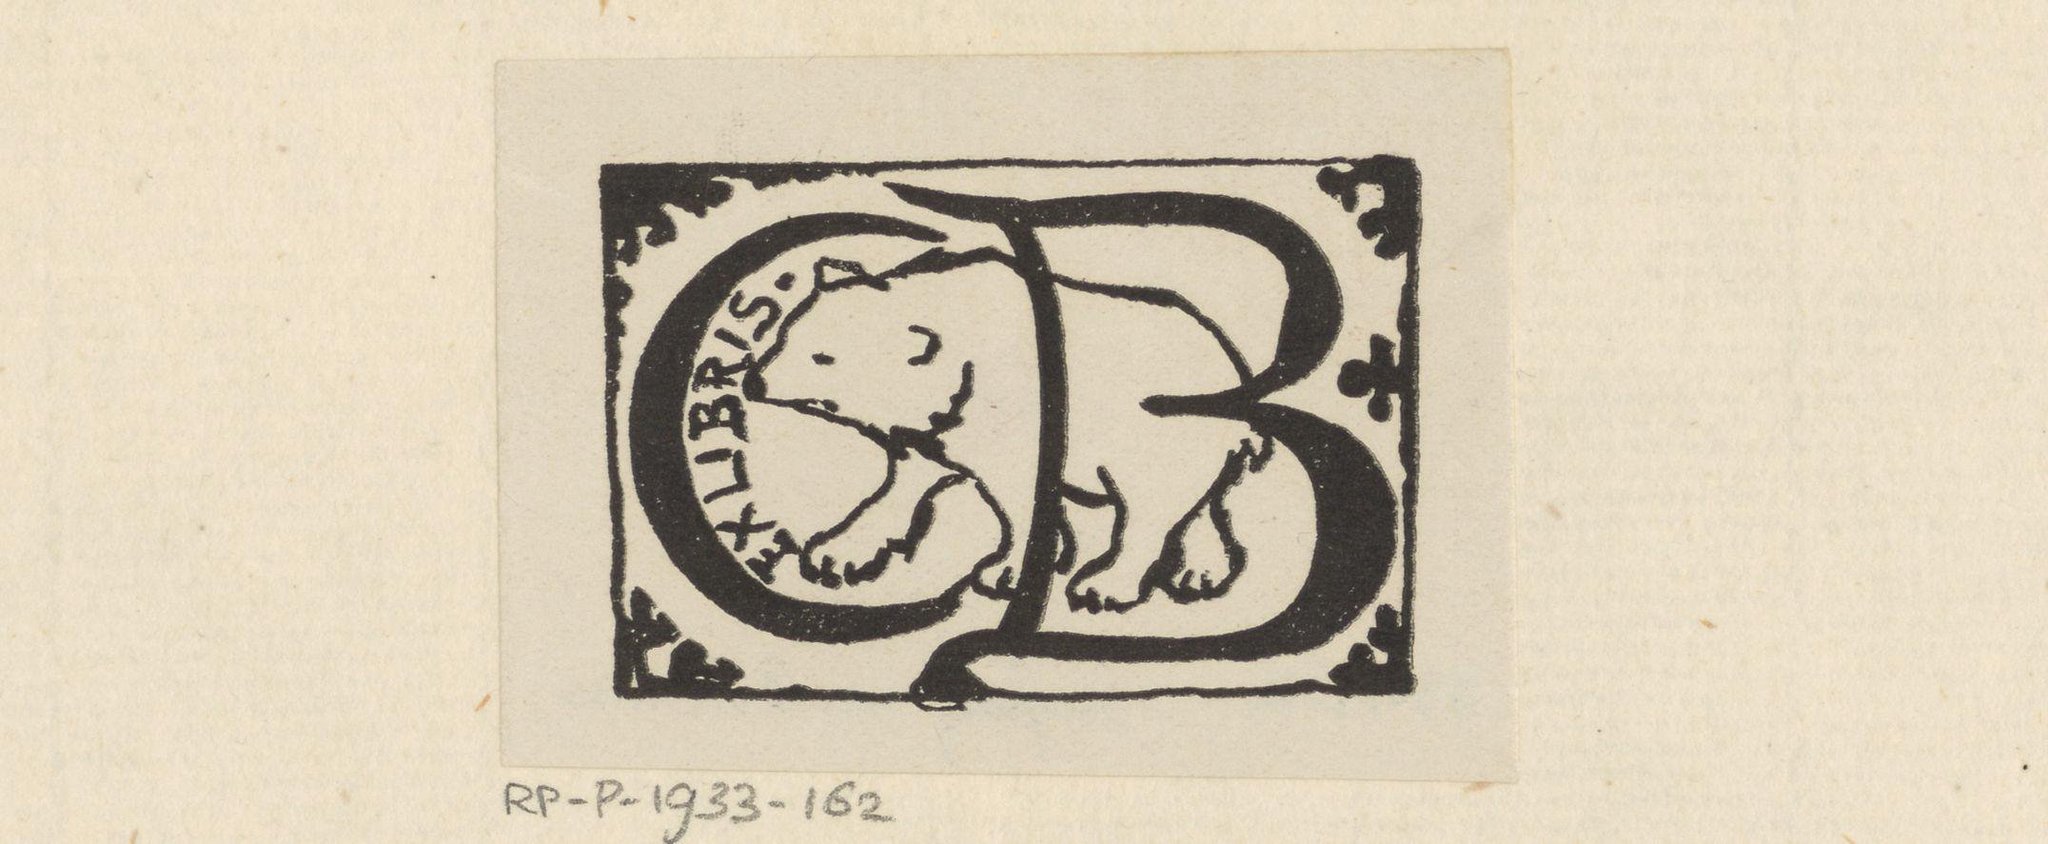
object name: bookplate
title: Ex libris van Cor Bruin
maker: Anonymous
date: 1870-1933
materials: paper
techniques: lithograph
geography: netherlands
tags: beasts of prey, predatory animals: bear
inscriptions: collector's mark: Lugt 2760, inscription: ‘de Graaf voor Cor Bruin’